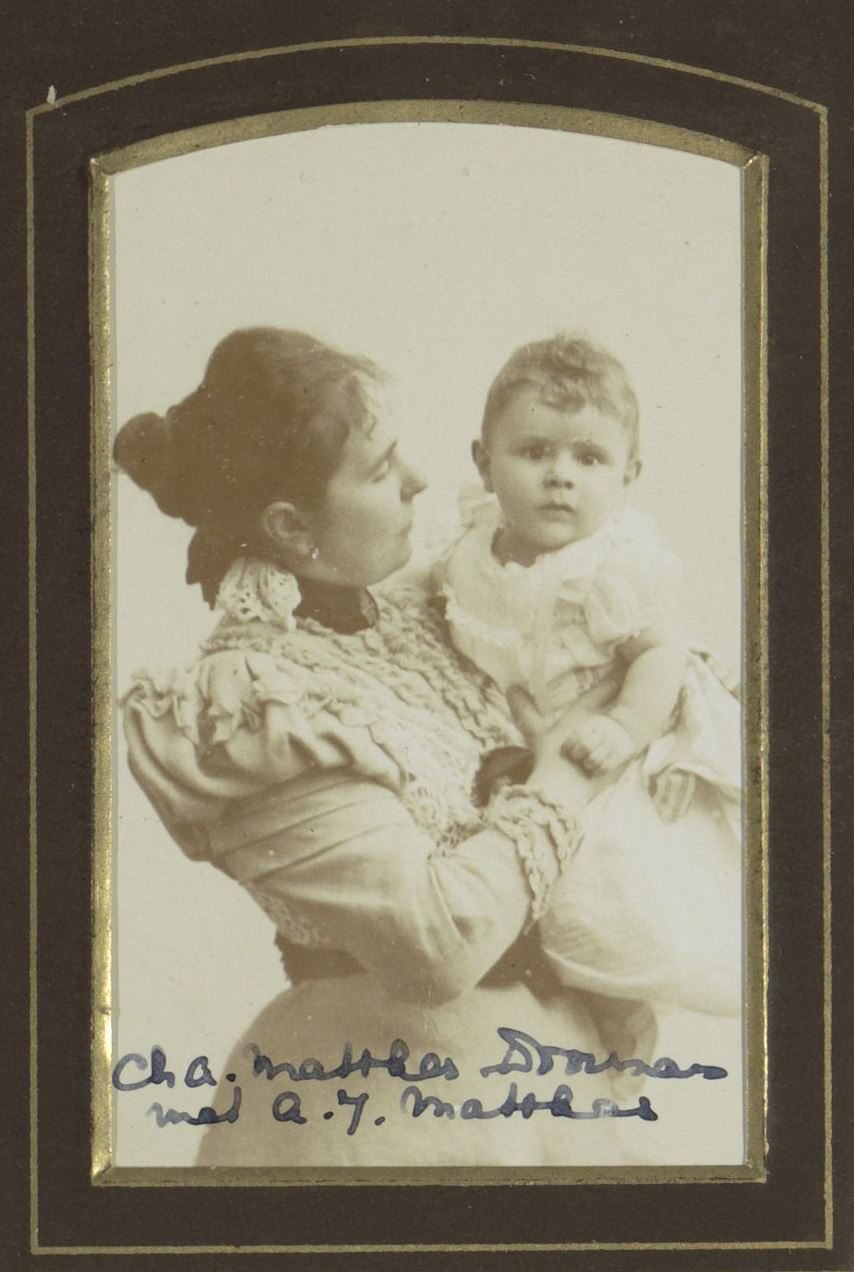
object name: album leaf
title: Portret van Cha. Matthes-Doorman met baby A.J. Matthes op de arm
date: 1881-1901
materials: cardboard, paper, photographic support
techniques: collodion silver print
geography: haarlem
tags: historical persons - bb - woman, mother and baby or young child, haarlem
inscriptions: address: ‘Haarlem Groote Houtstraat 84, 's Bosch a/d Parade’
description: Onderdeel van Fotoalbum van de families Matthes, Doorman en Van Thiel.